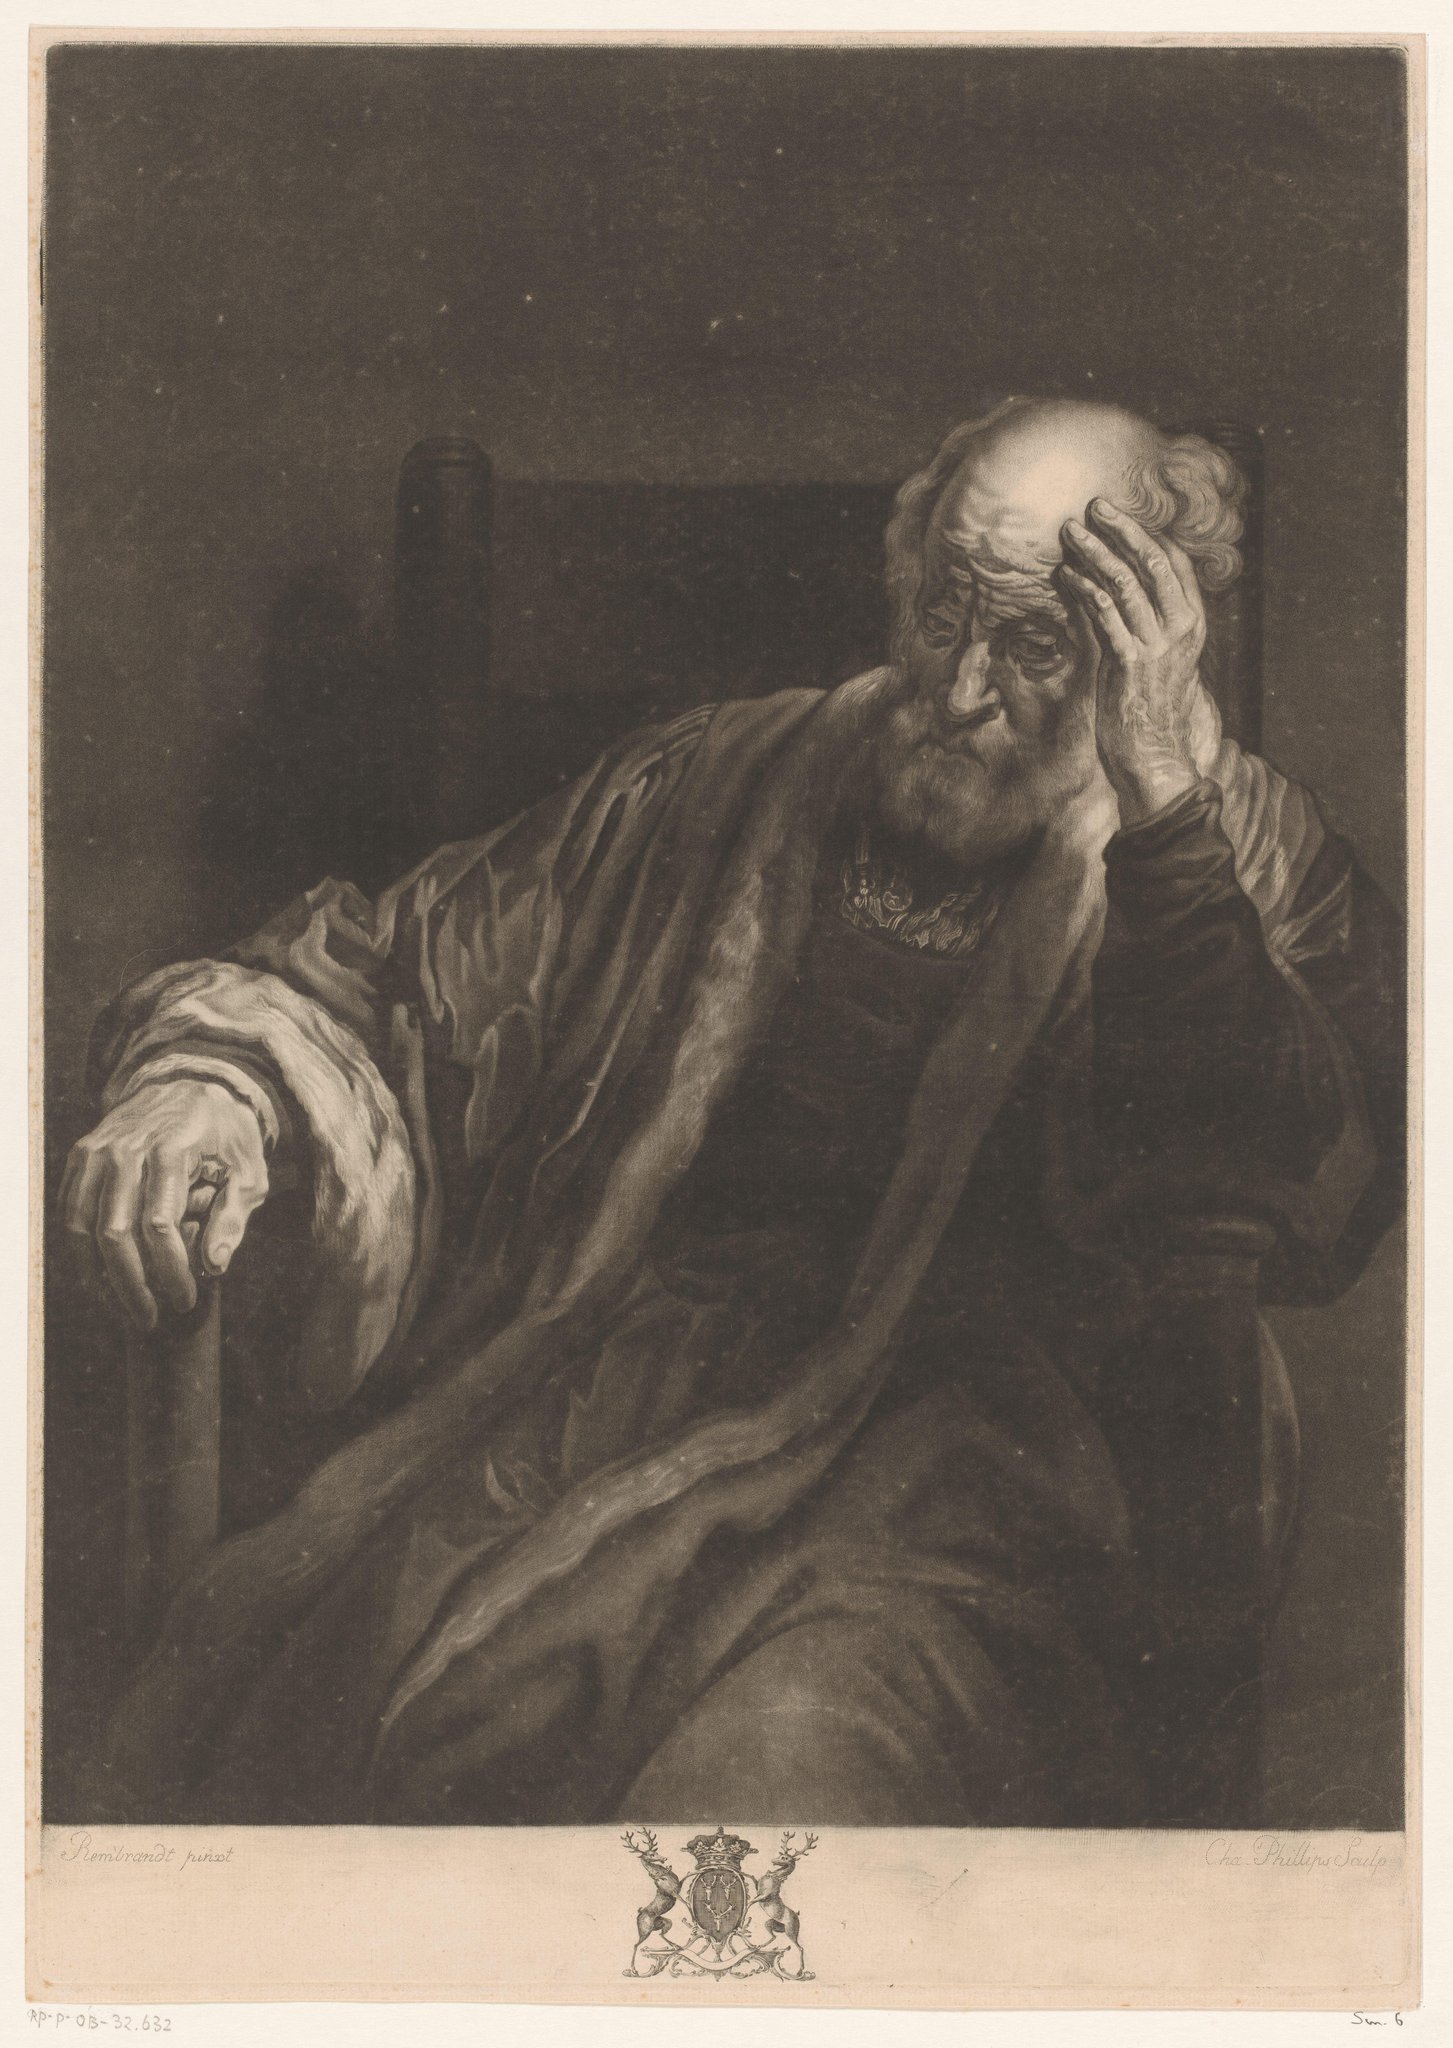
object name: print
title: Zittende oude man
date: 1747-1773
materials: paper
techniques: etching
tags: old man, scholar, philosopher (+ portrait of scholar, scientist)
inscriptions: collector's mark: Lugt 240